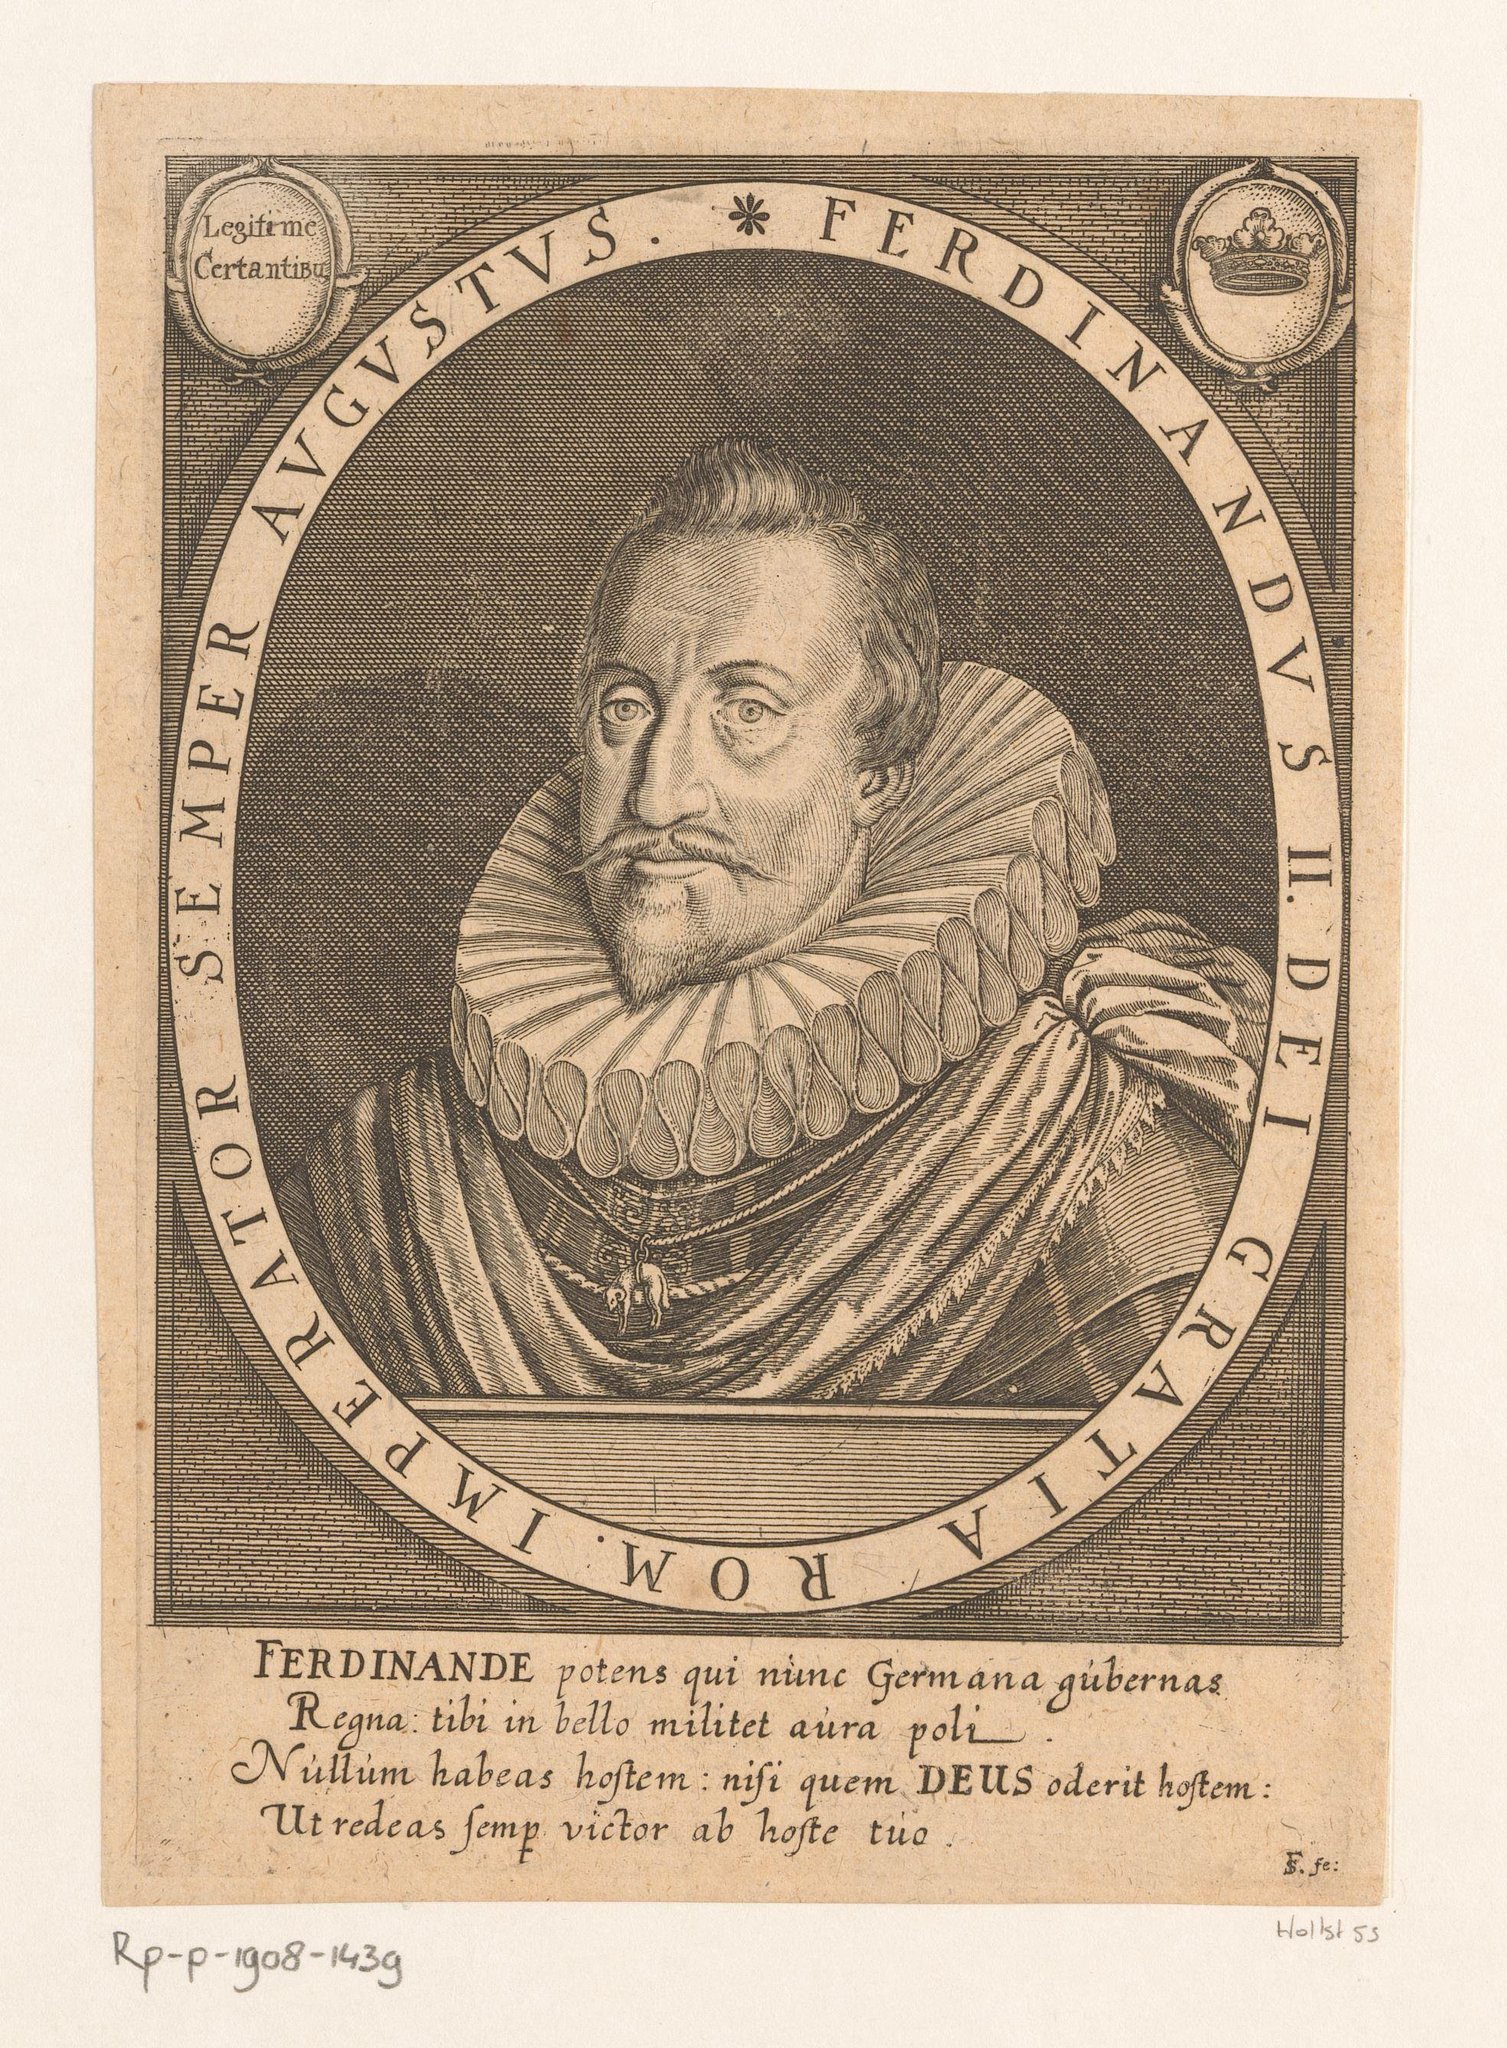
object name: print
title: Portret van Ferdinand II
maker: sebastian furck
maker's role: print maker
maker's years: 1600-1655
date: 1641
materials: paper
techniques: engraving, etching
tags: vienna, ferdinand ii (duits keizer), historical persons, emperor, knighthood order of the golden fleece - insignia of a knighthood order, e.g.: badge, chain (with name of order), abstract ideas and concepts (+ emblematical representation of concept)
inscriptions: collector's mark: Lugt 2228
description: Prent gebruikt voor: Helvicus, Nicolaus. Theatrum Historiae universalis Catholico Protestantium (...). Frankfurt am Main: Johann Gottfried Schönwetter, 1641.